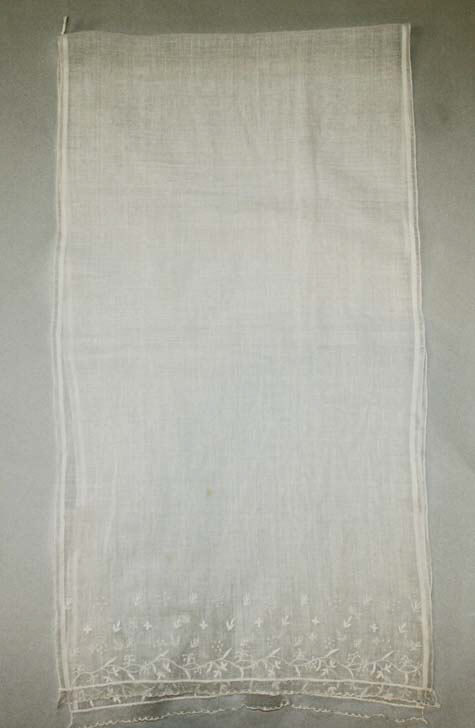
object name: fichu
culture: british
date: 1776-1800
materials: cotton